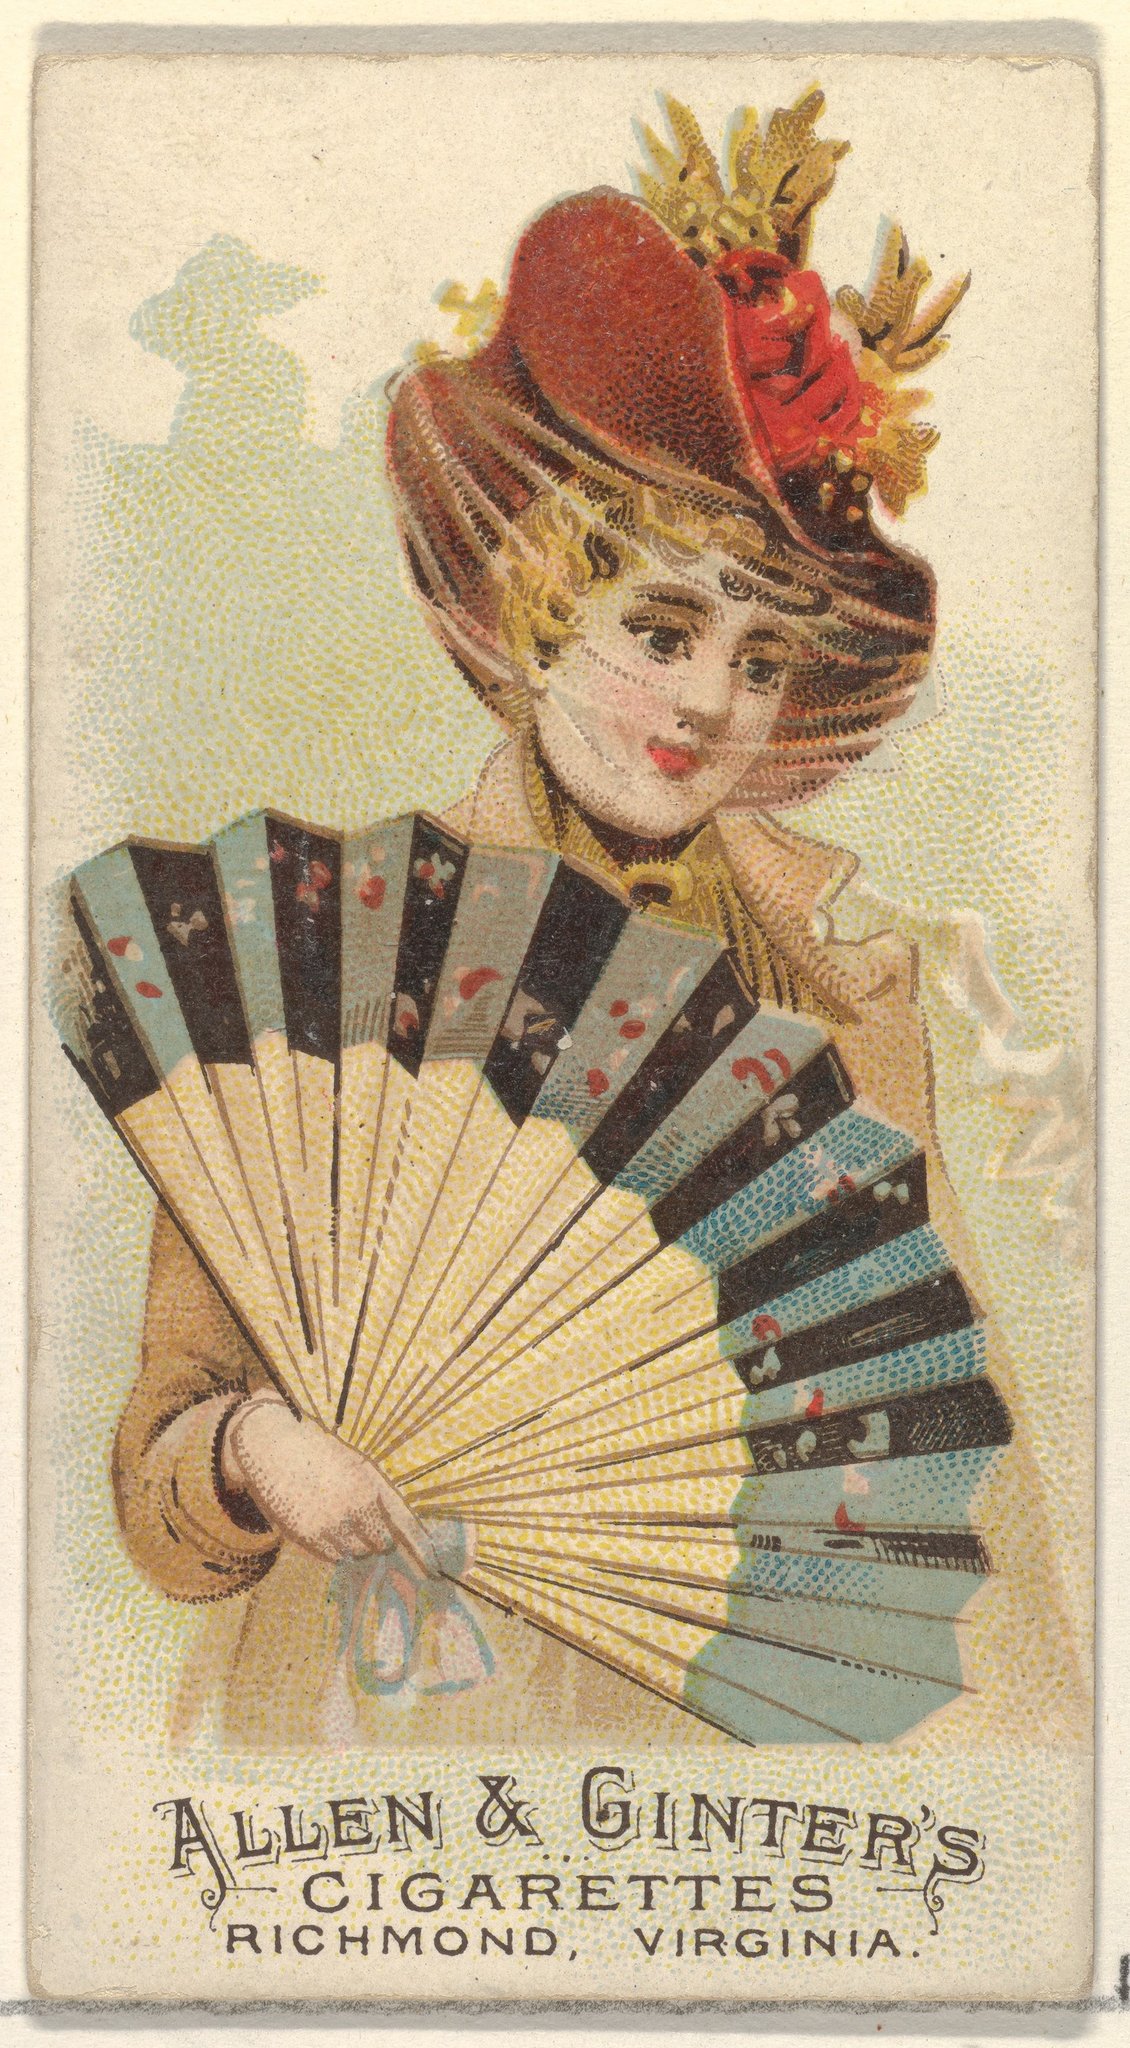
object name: print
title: Plate 33, from the Fans of the Period series (N7) for Allen & Ginter Cigarettes Brands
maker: allen & ginter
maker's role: publisher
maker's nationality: american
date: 1889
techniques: color lithograph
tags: fans,women